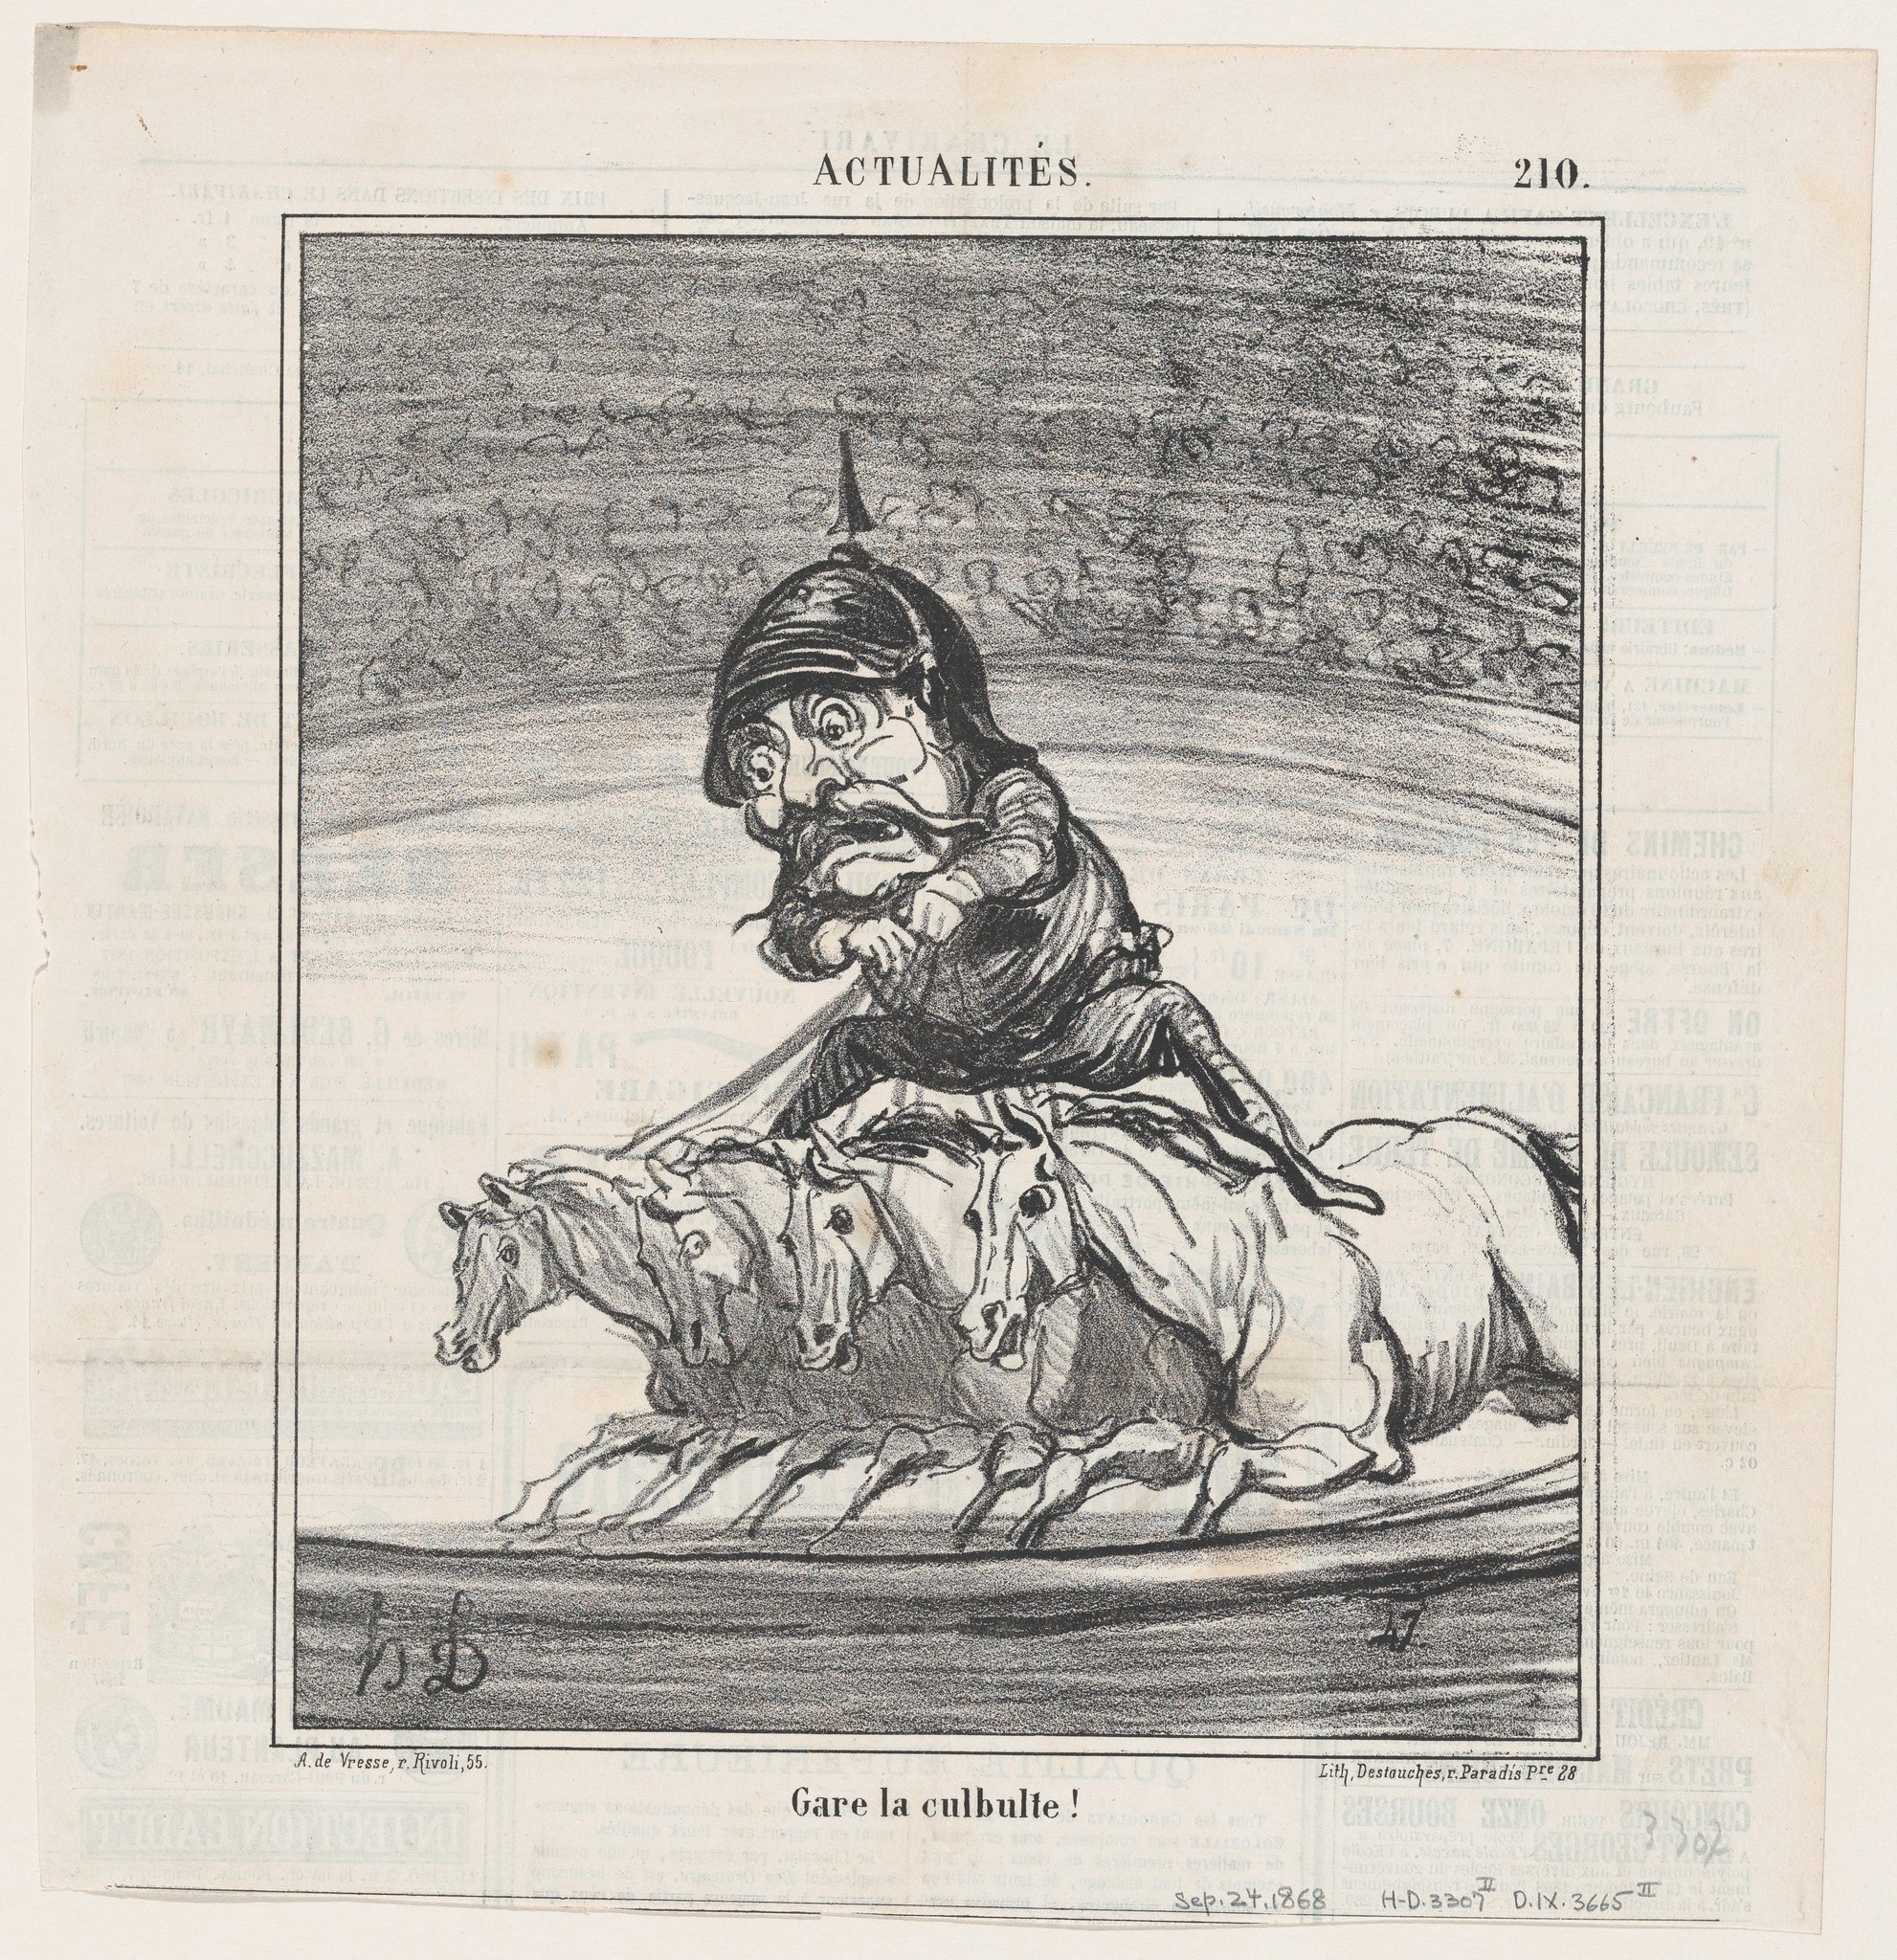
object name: print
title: Beware of the fall!, from 'News of the day,' published in Le Charivari, September 24, 1868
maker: honoré daumier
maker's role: artist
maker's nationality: french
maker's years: 1808-1879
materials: paper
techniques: lithograph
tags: satire,men,horses